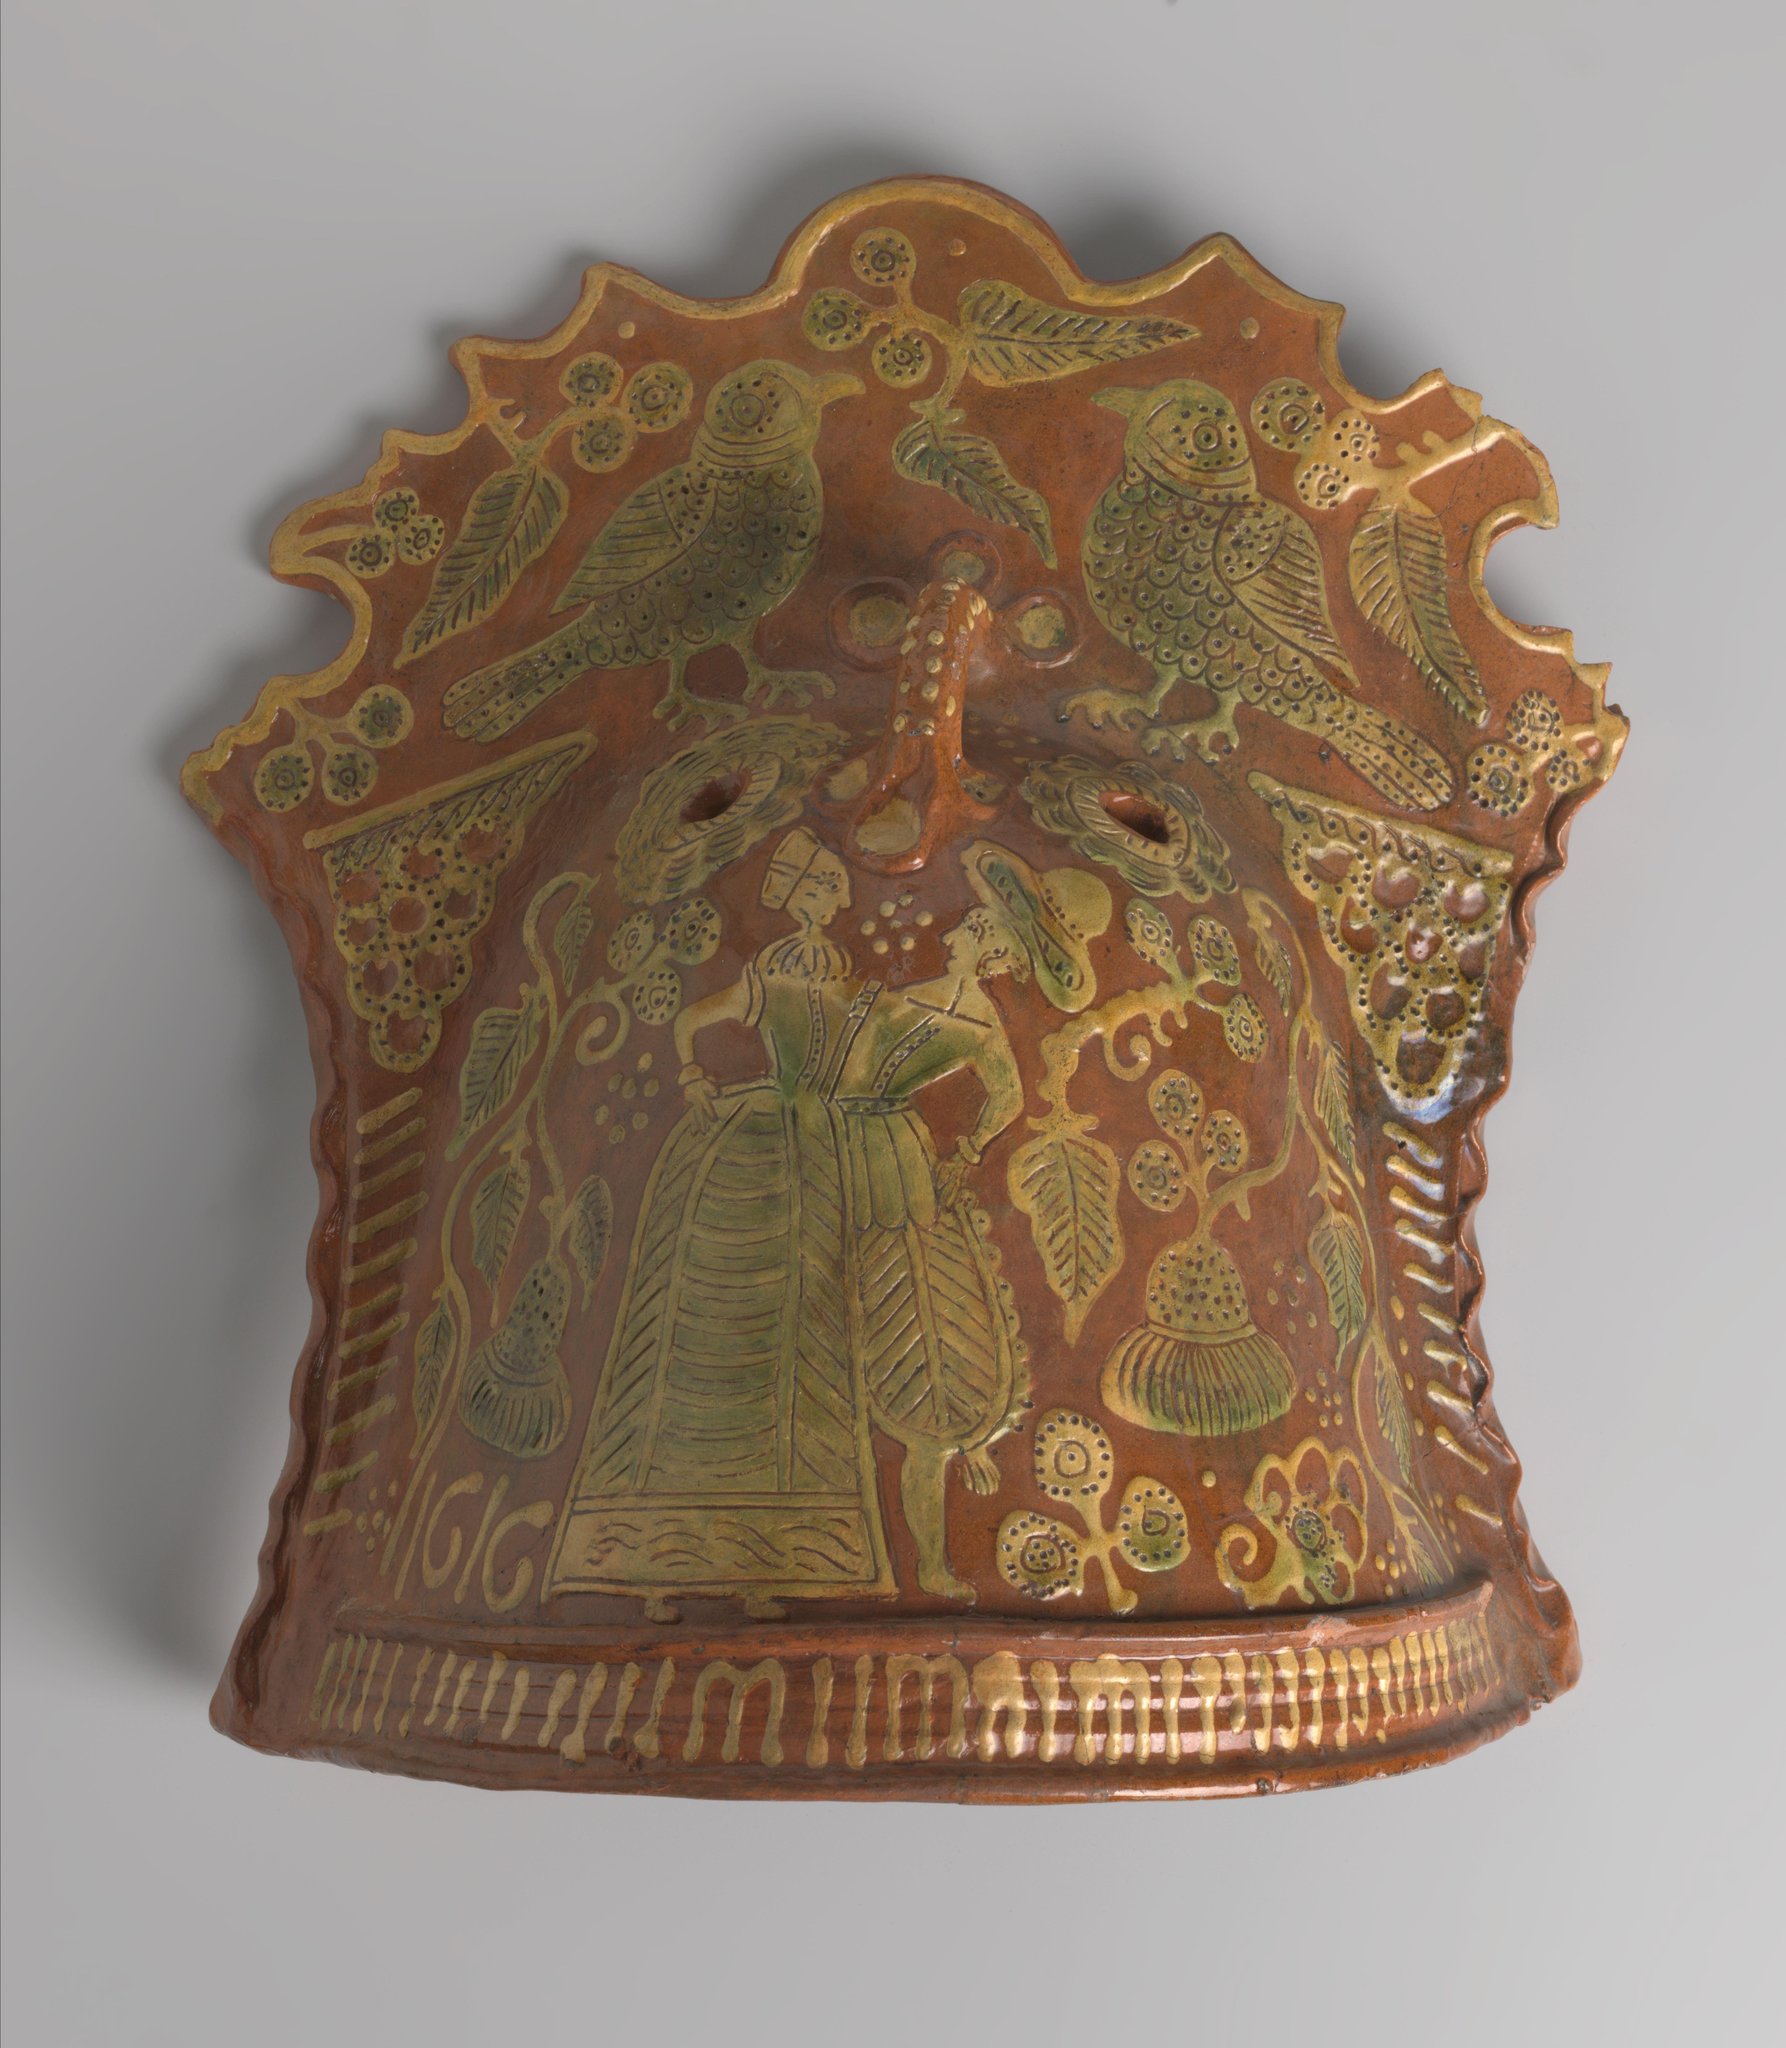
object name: vuurstolp, vuurklok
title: Vuurstolp van loodglazuuraardewerk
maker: Anonymous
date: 1616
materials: earthenware, glaze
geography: north holland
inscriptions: date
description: Halfronde vuurstolp van loodglazuuraardewerk, met vleugels. De stolp is onder het handvat versierd in witte slib met een dansende (?) man en vrouw, omgeven door takken met bloemen en bladeren. Op de vleugels twee elkaar aanziende vogels. De stolp is links onder gedateerd: 1616.